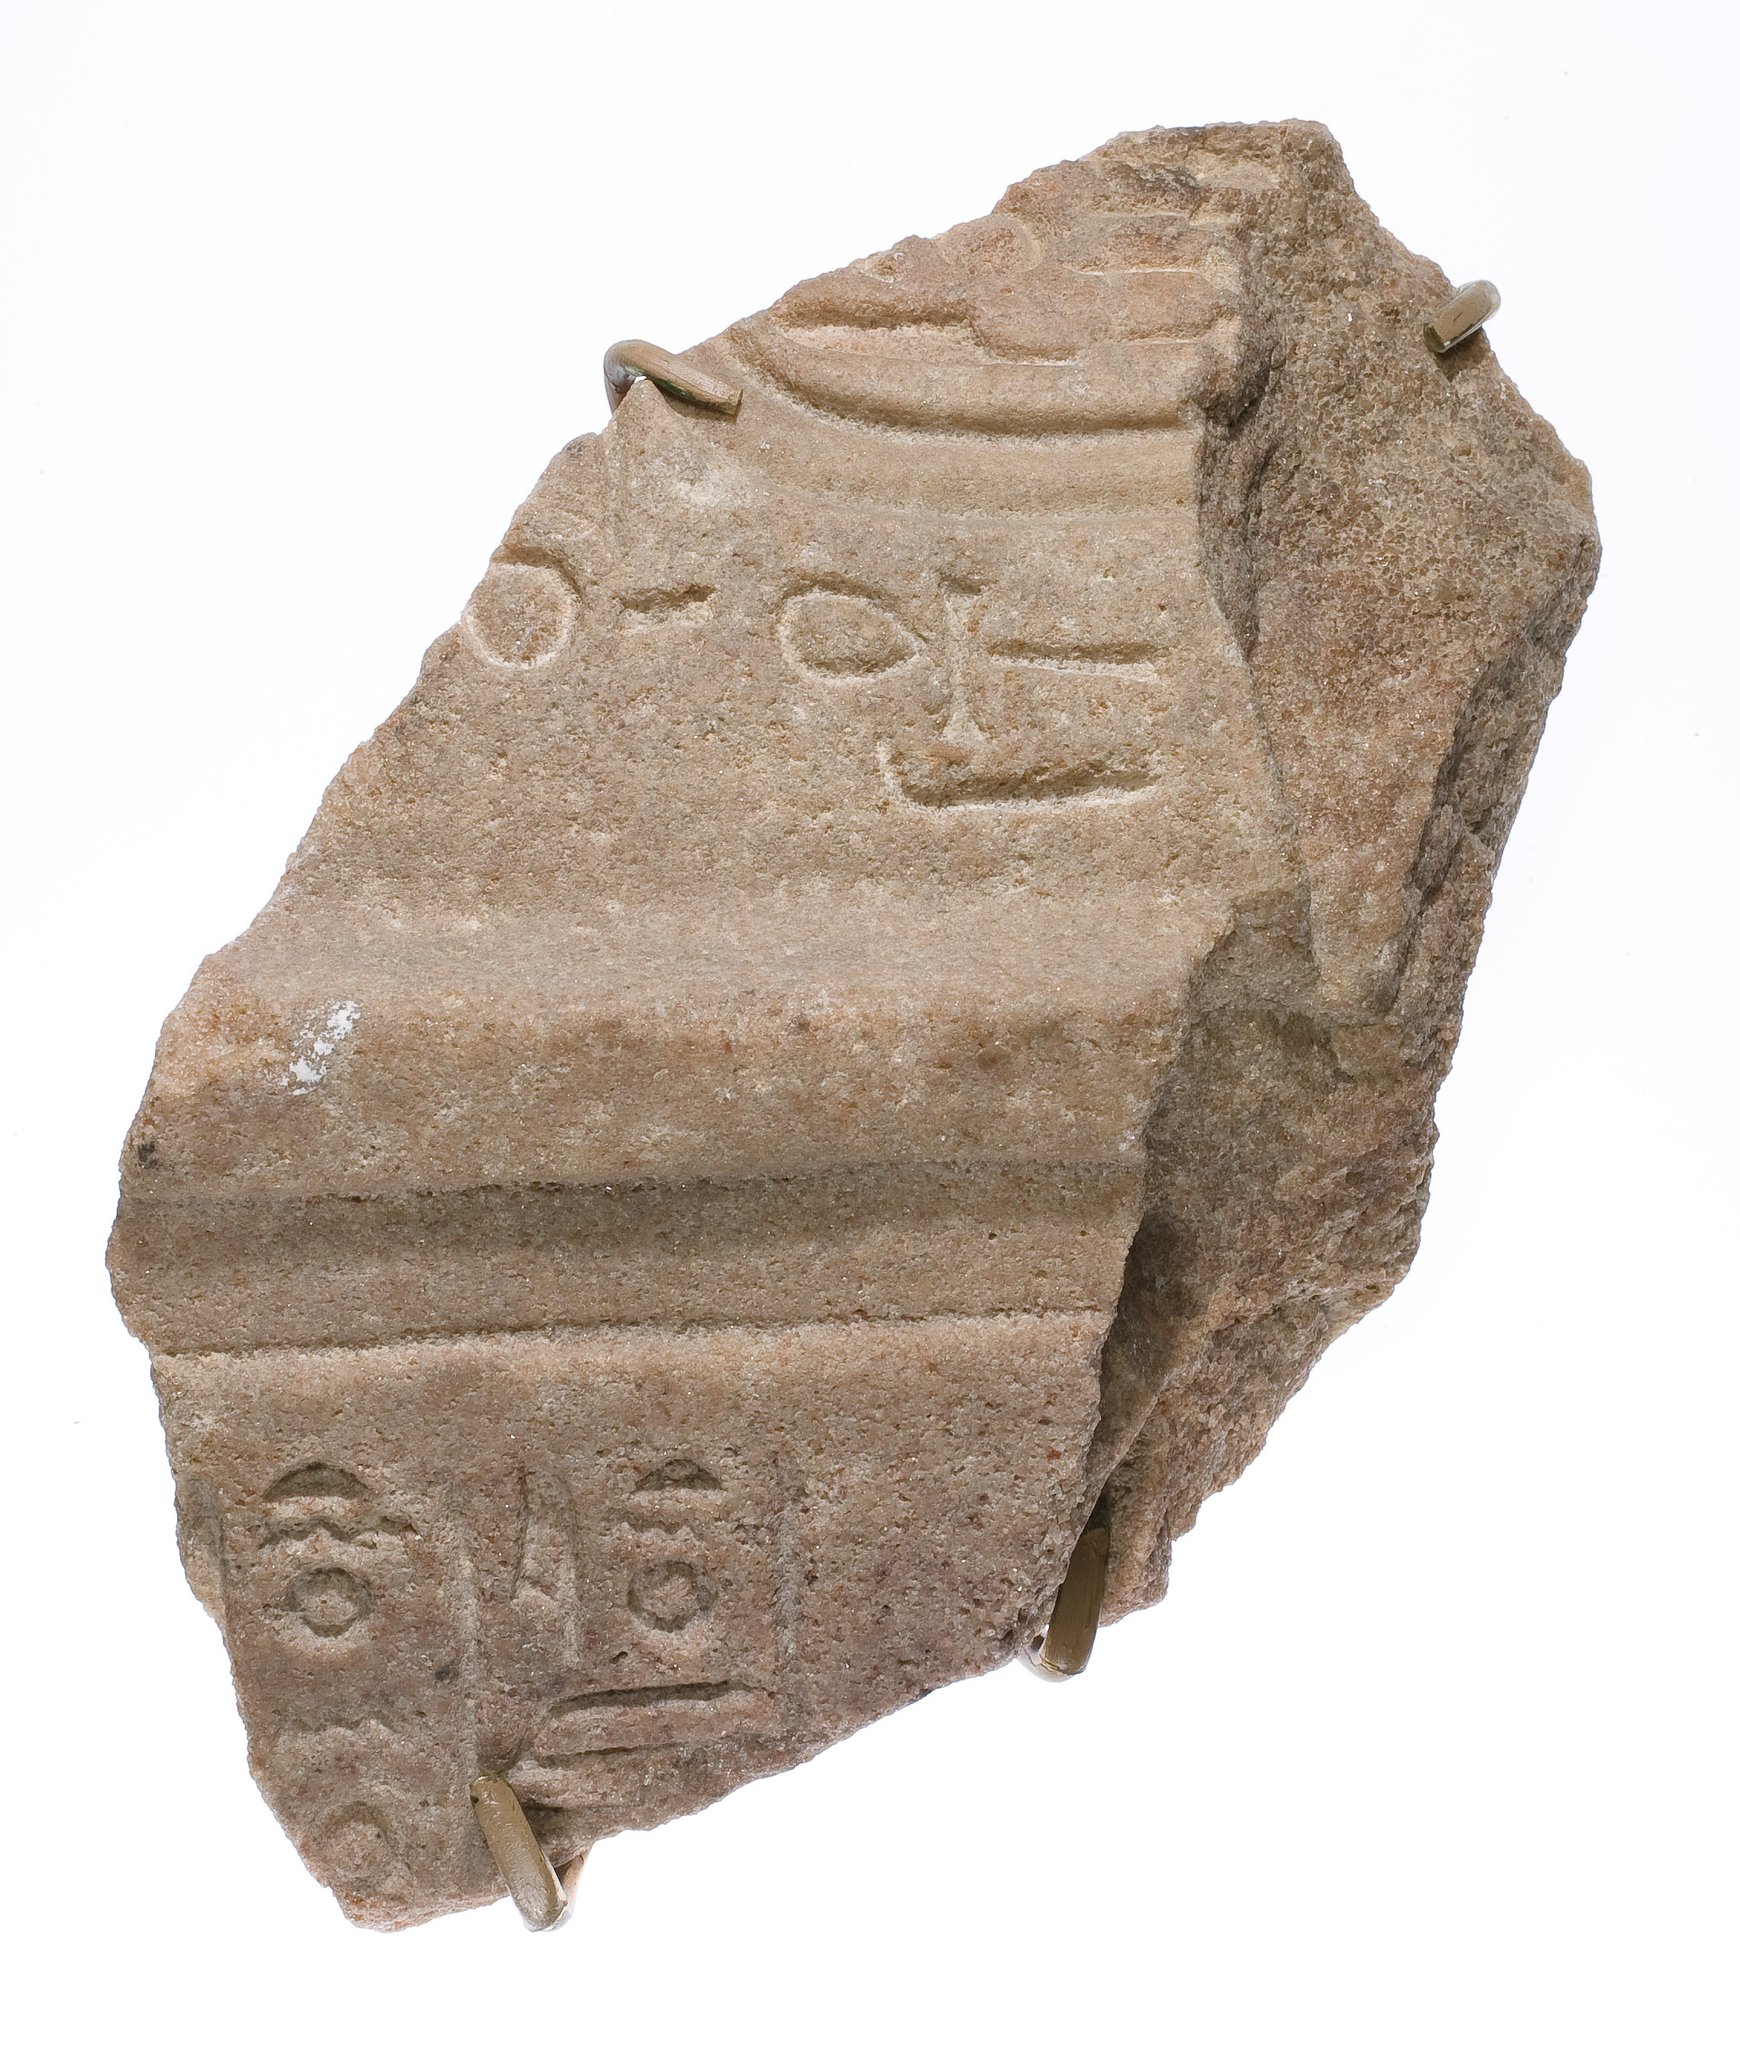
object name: balustrade fragment, cartouche of nefertiti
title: Balustrade fragment with cartouche of Nefertiti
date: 1352-1336 BCE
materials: quartzite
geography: egypt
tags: cartouches